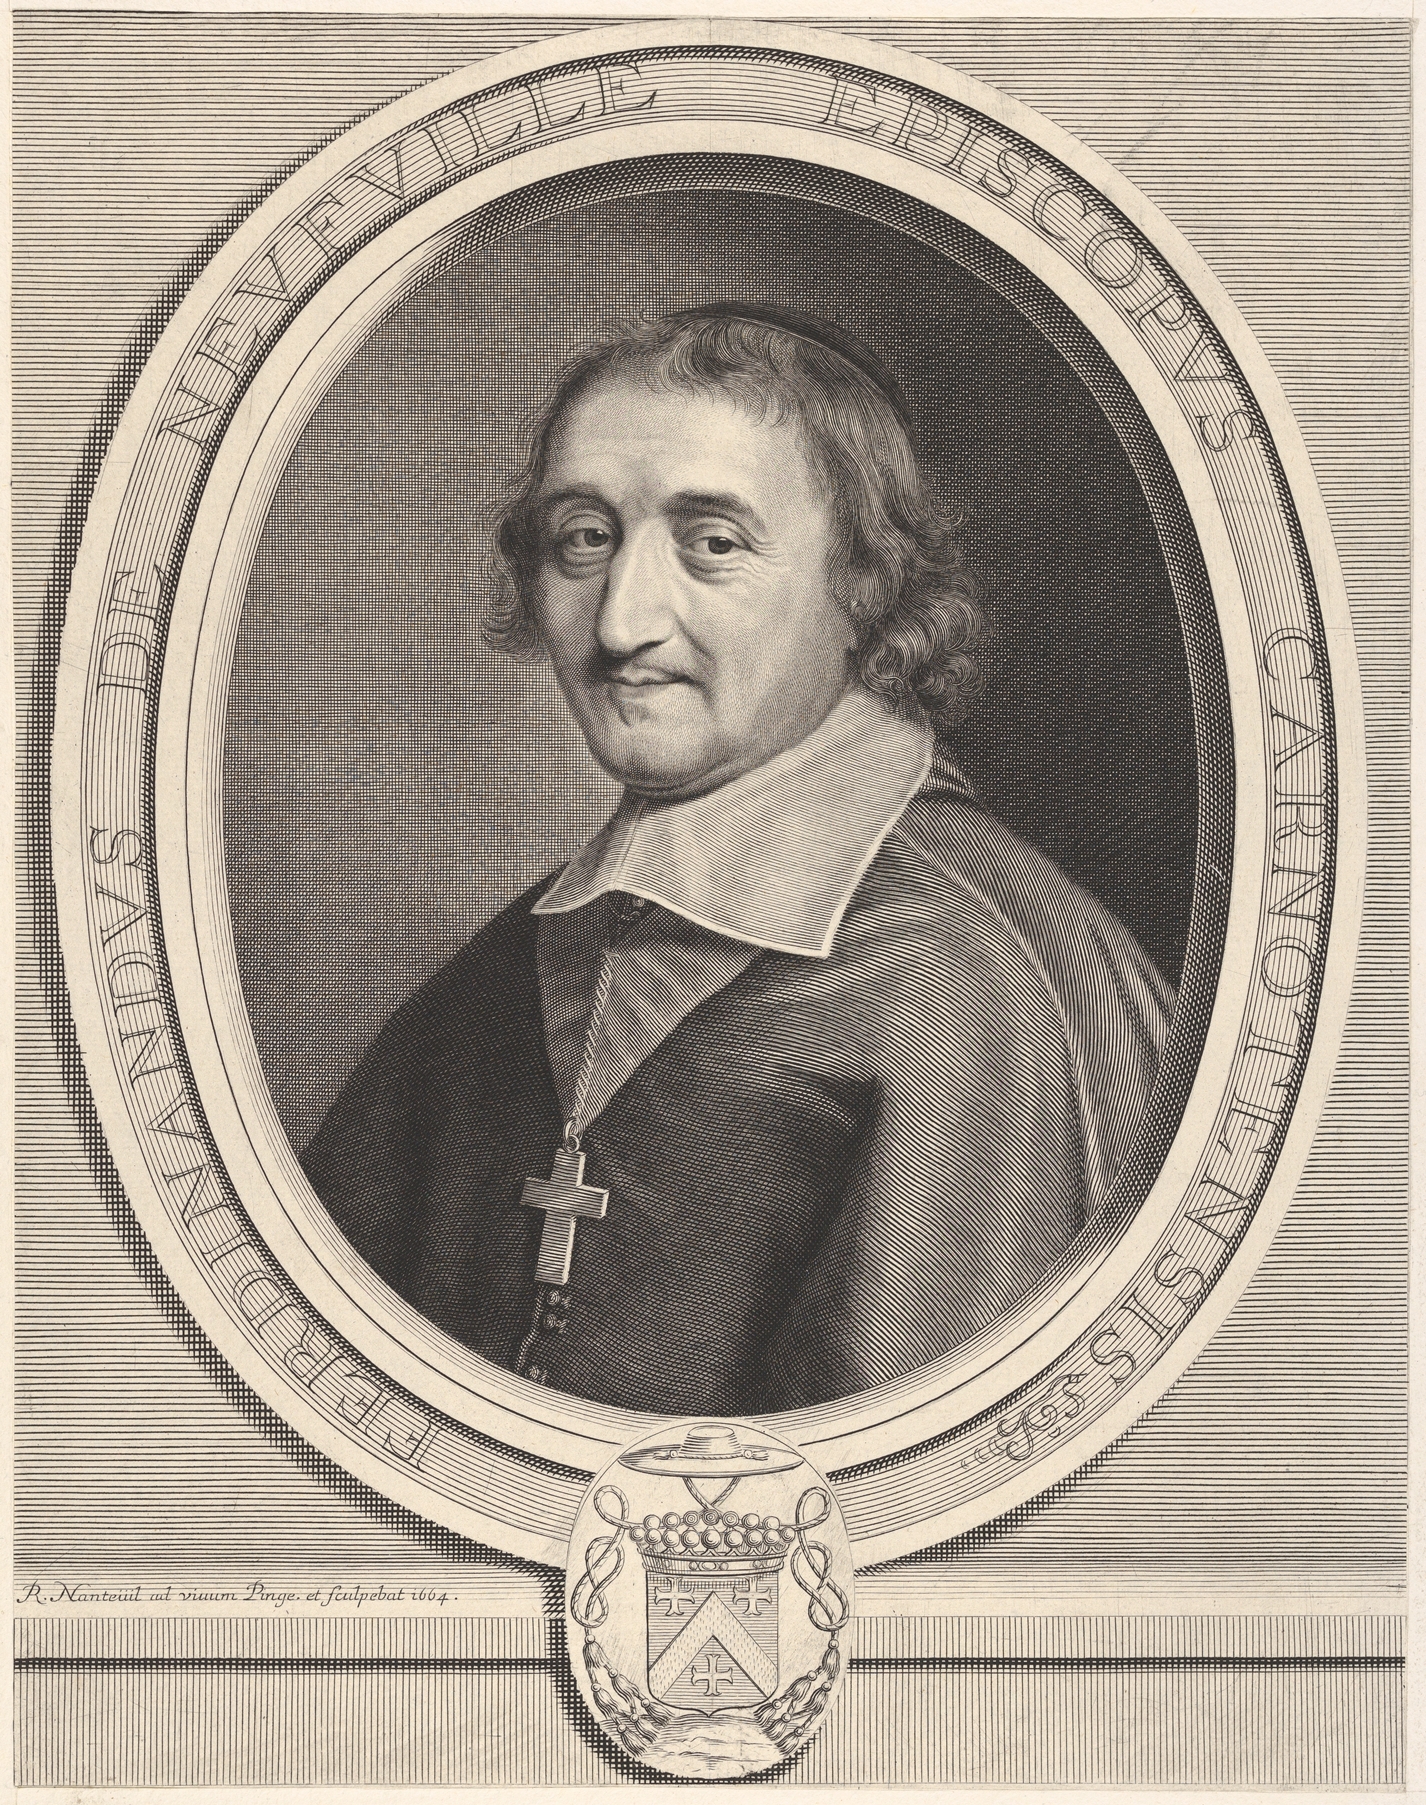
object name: print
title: Ferdinand de Neufville de Villeroy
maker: robert nanteuil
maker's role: artist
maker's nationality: french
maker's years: 1623-1678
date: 1664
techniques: engraving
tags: men,portraits,cross,coat of arms